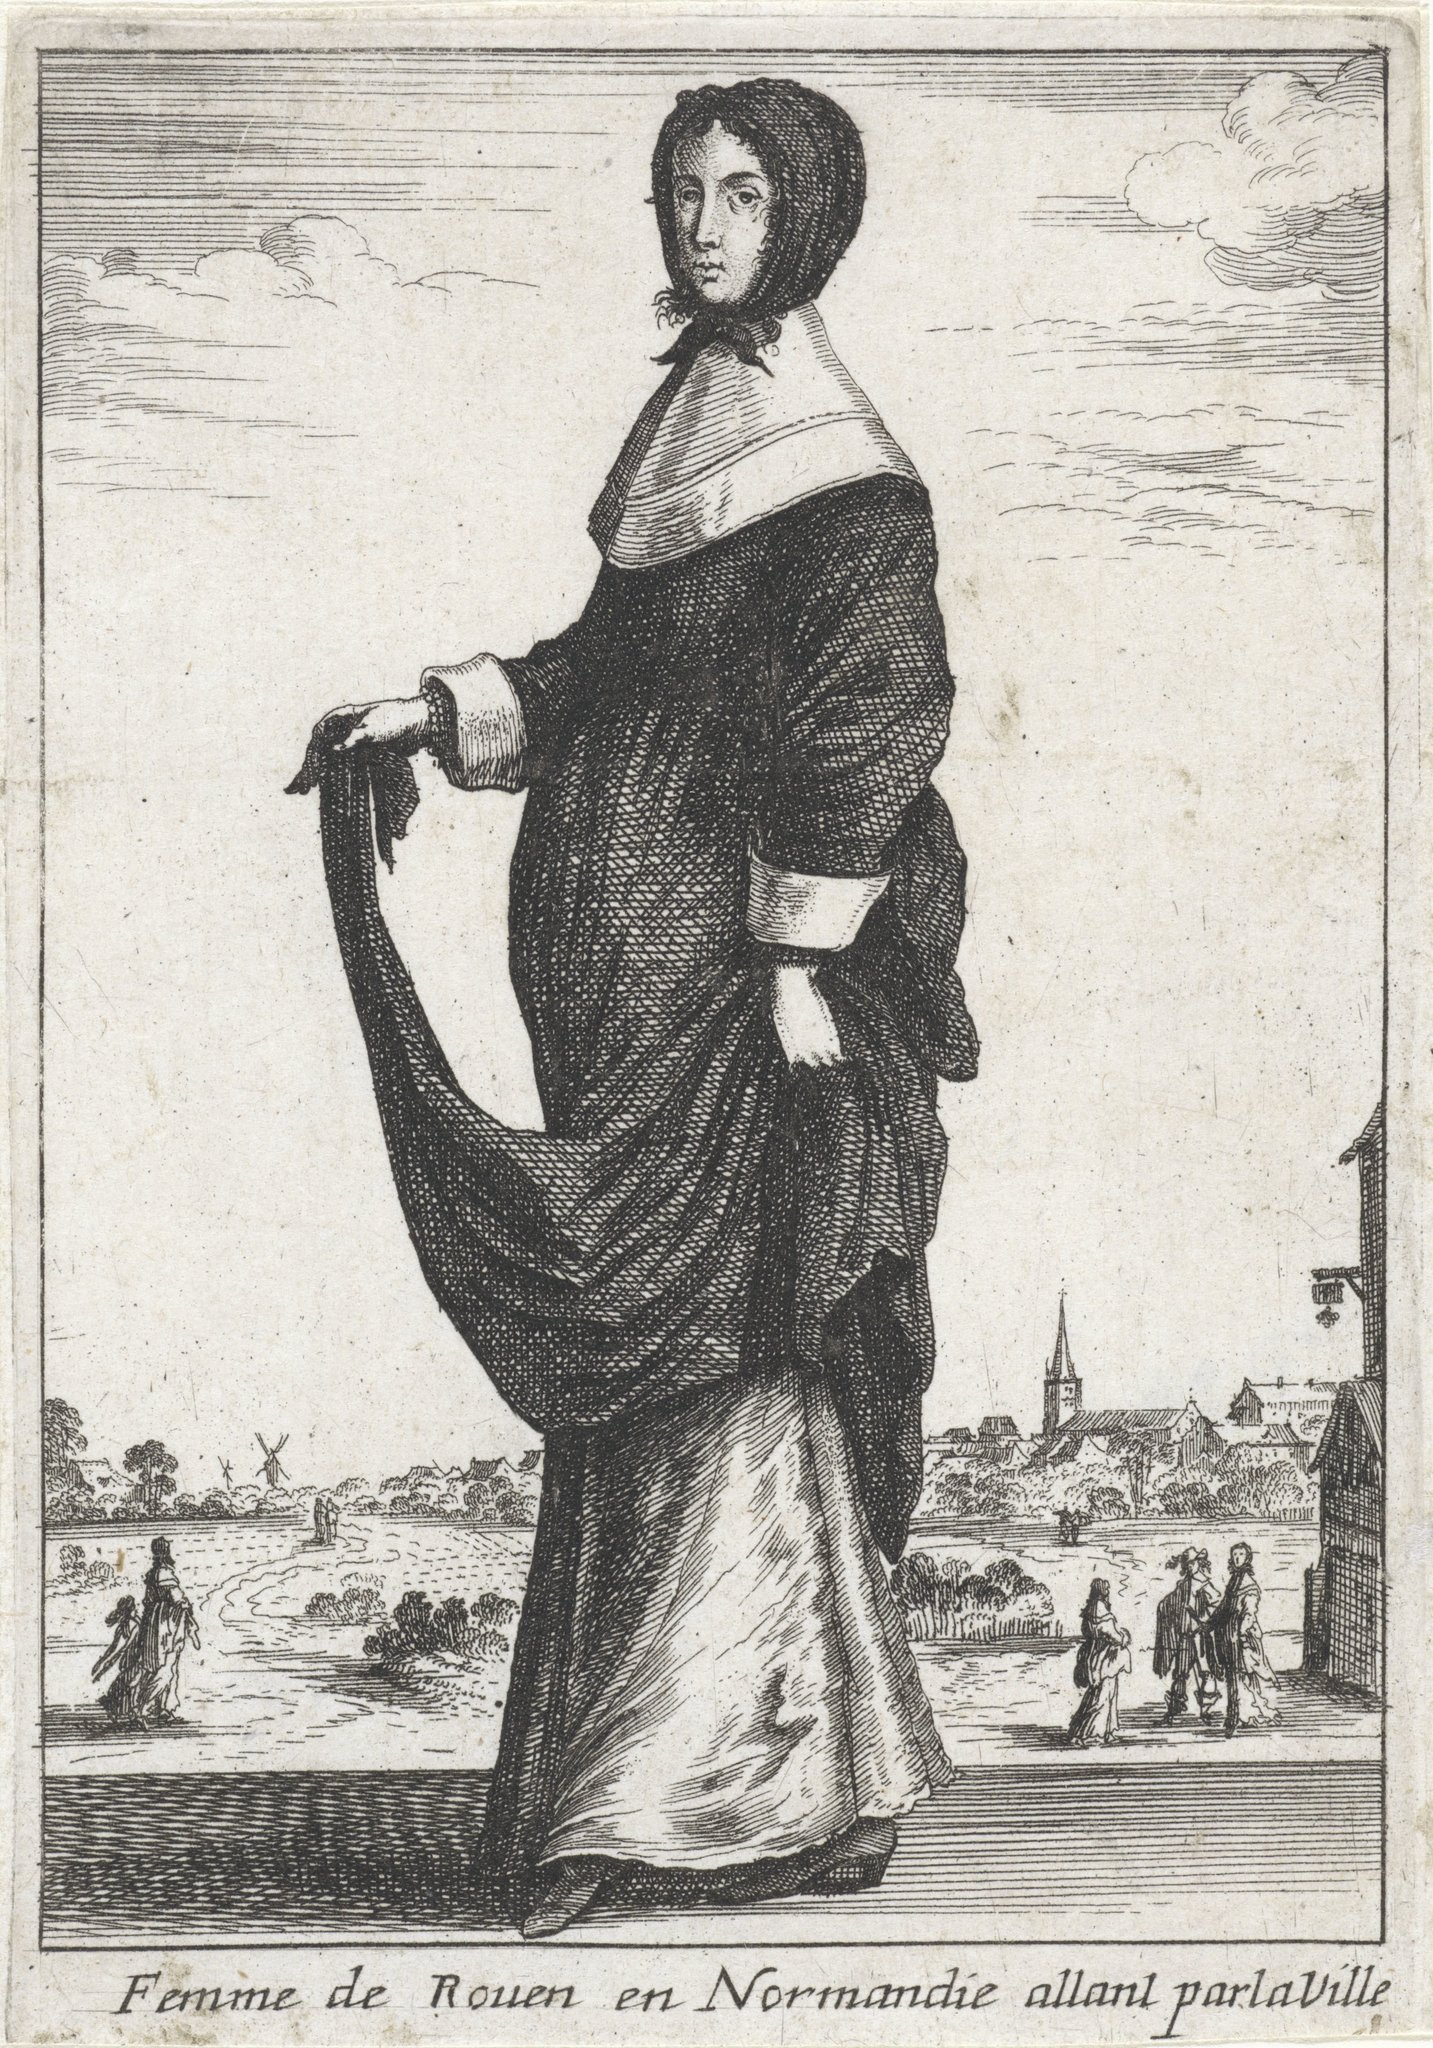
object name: costume print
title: Femme de Rouen en Normandie allant par la Ville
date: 1662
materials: paper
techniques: etching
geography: paris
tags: rouen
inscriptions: collector's mark: Lugt 240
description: De prent maakt deel uit van de 28-delige serie (excl. titelprent) met voorstellingen van vrouwen in verschillende klederdrachten, getiteld "Livre curieux contenant la naifue representations des habits des femmes des diverses parties du Monde (...), 1662".